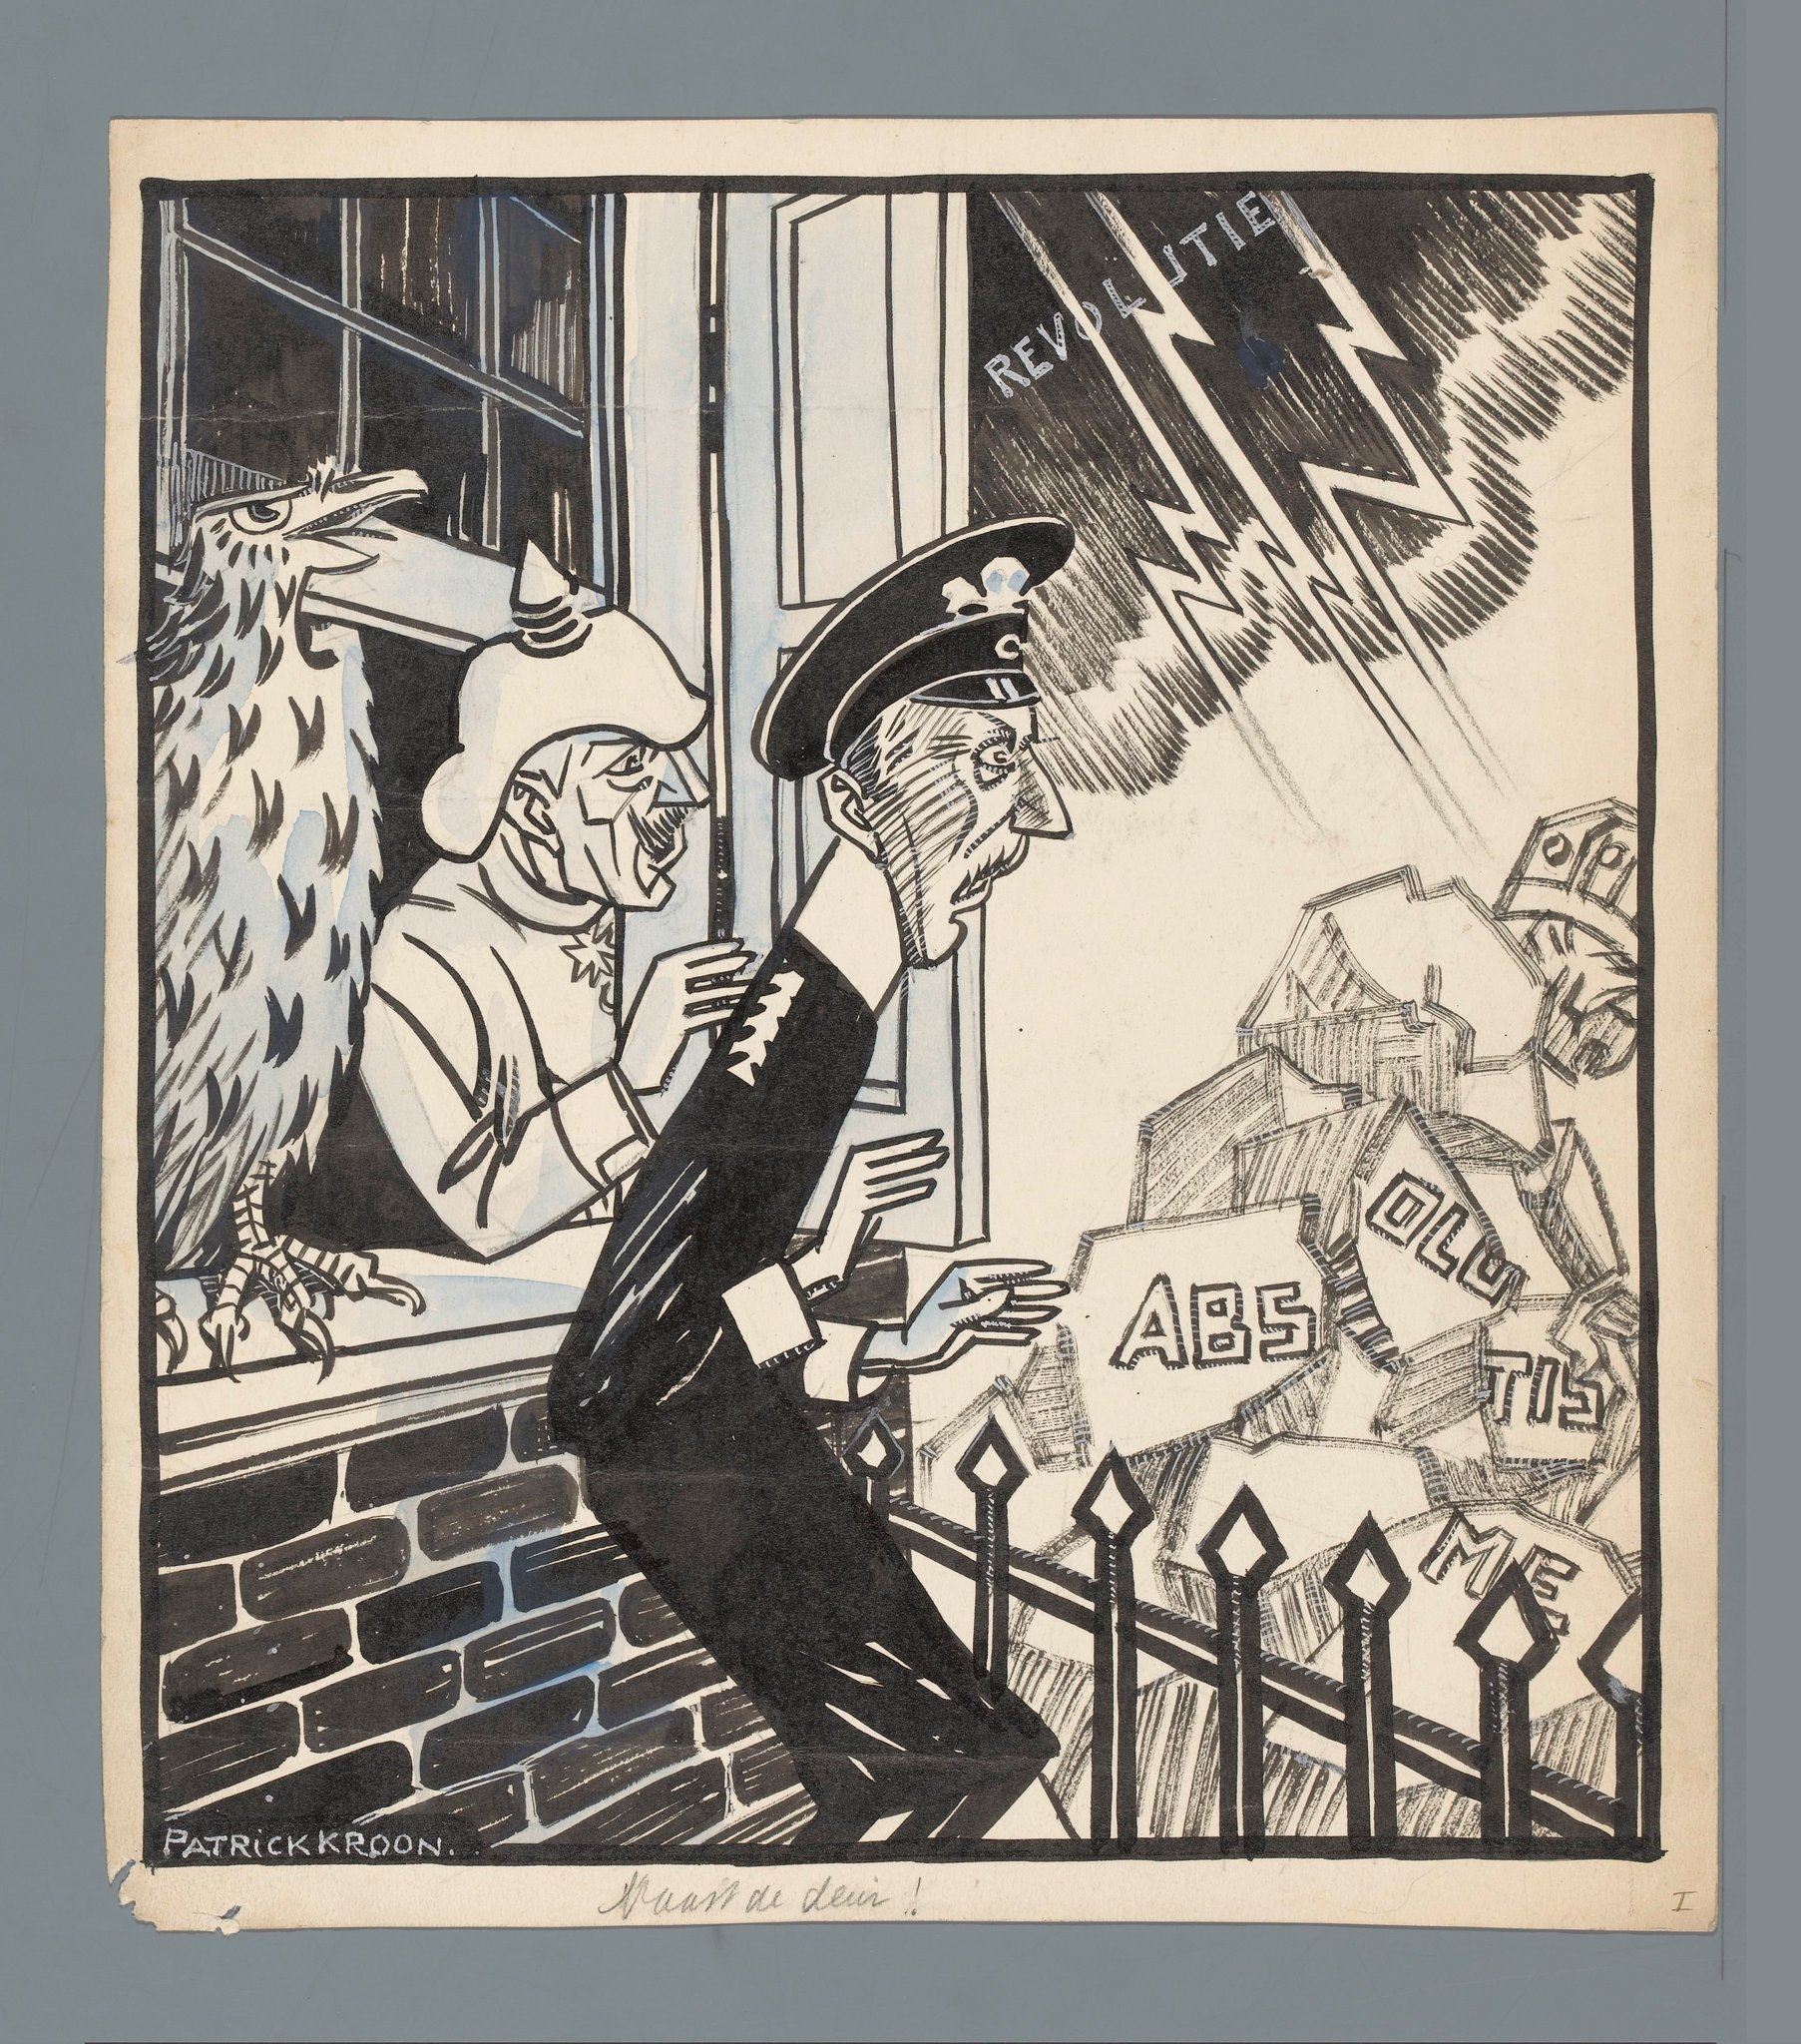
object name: drawing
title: Revolutie naast Duitsland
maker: patricq kroon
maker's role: draughtsman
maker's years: 1862-1941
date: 1917-1918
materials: ink, paint, paper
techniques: brush, pen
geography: netherlands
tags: wilhelm ii (keizer van duitsland), the old government and its supporters (after revolution), lightning, flash of lightning, thunderbolt, political caricatures and satires, germany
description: Vanuit een huis kijken keizer Wilhelm II, een andere Duitse politicus en de rijksadelaar toe hoe het naast gelegen huis 'Absolutisme' door de bliksem van revolutie wordt getroffen en in elkaar stort. Naar aanleiding van de Russische Revolutie in 1917. Ontwerp voor een politieke spotprent.